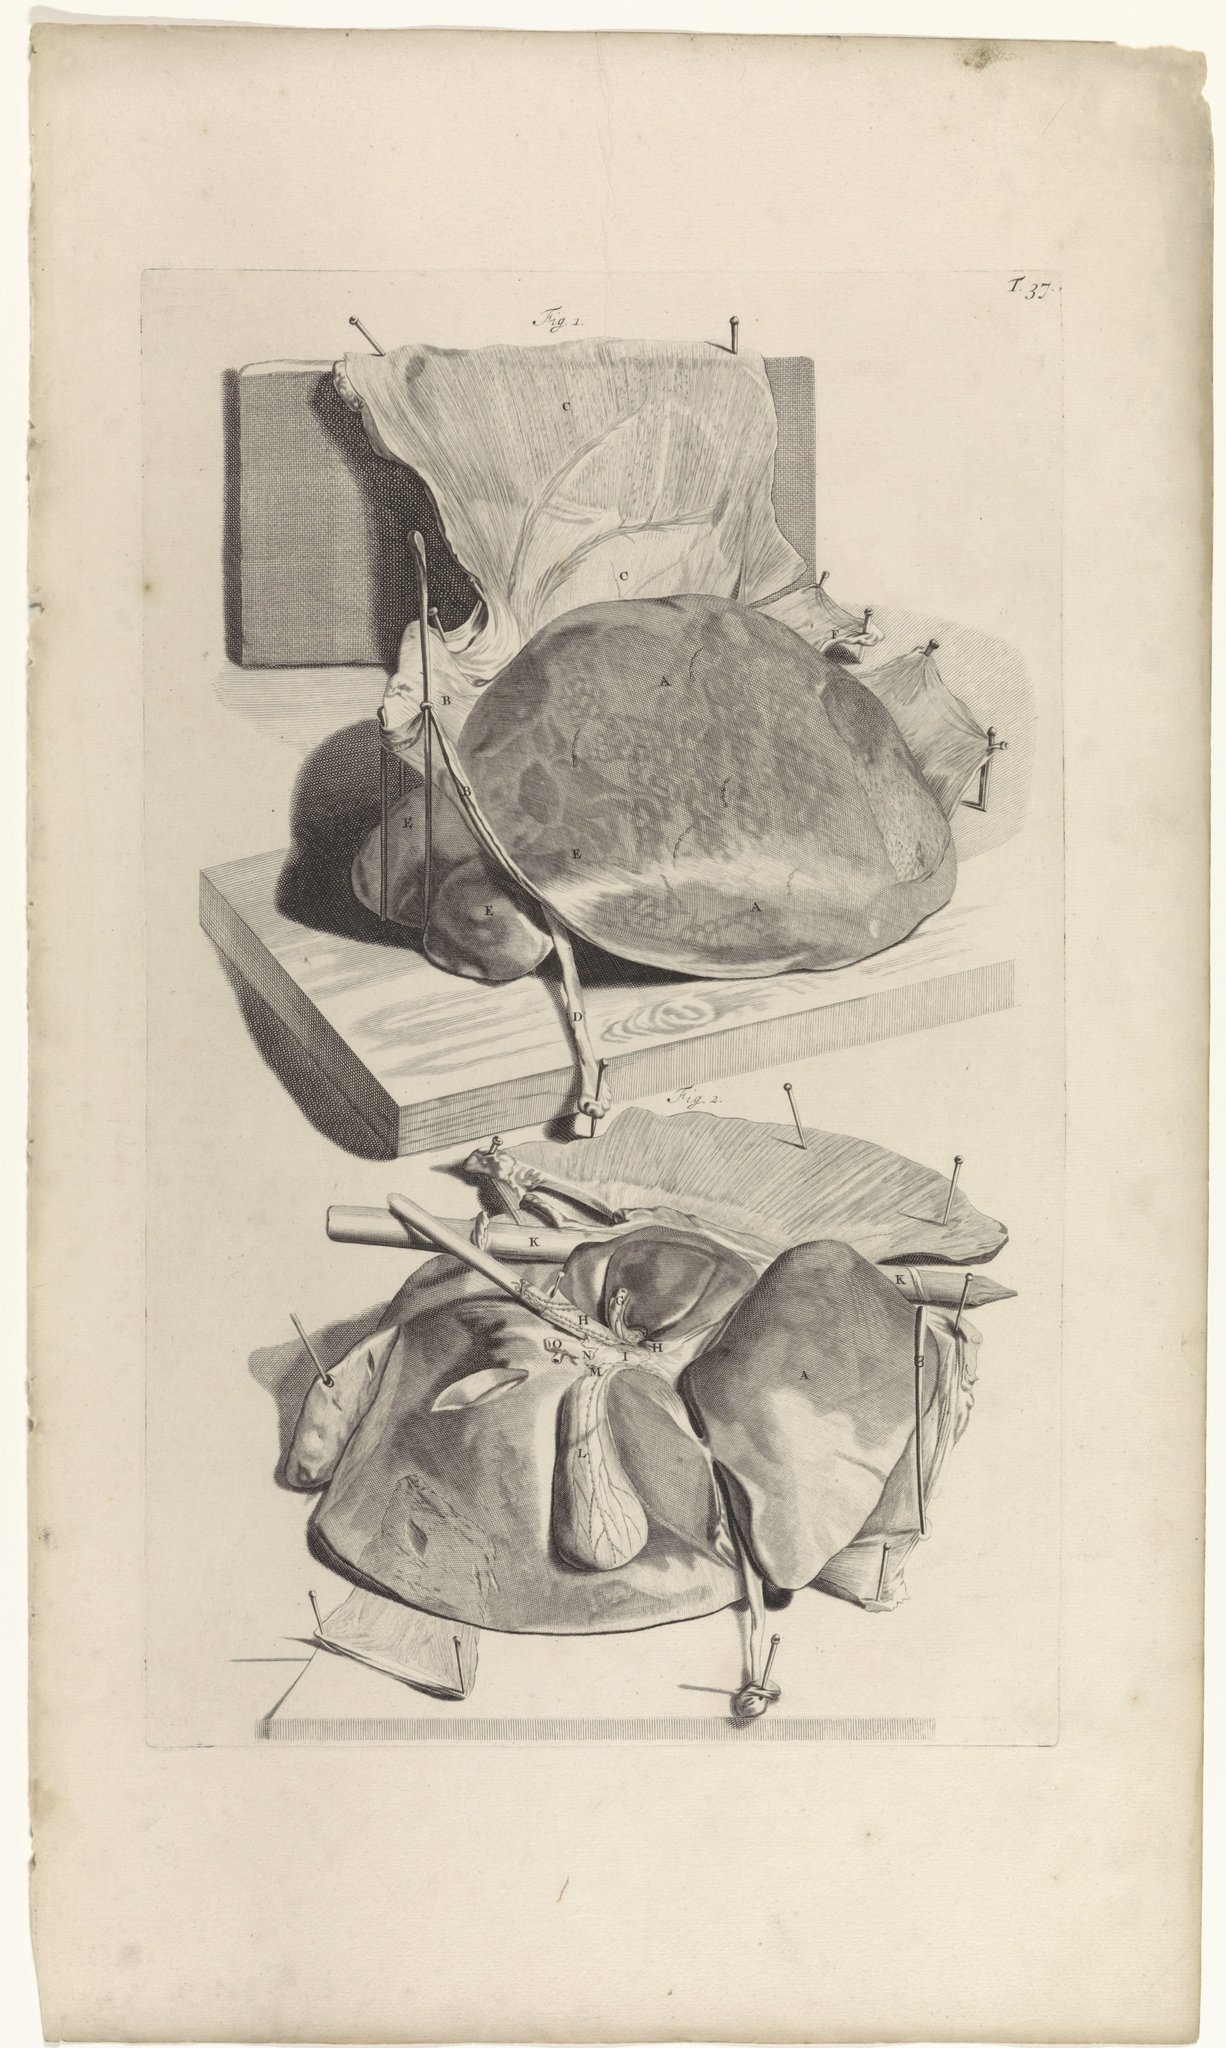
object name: print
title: Anatomische studie van de lever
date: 1685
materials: paper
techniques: engraving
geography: amsterdam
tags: liver (human anatomy)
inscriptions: collector's mark: Lugt 2228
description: Boekillustratie voor Bidloo, Godefridus. Anatomia humani corporis centum & quinque tabulis, per art. G. de Lairesse ad vivum delineatis, de monstrata, veterum recentiorumque inventis explicata plurimisque, hactenus non detectis, illustrata. Amsterdam: Weduwe Joannes van Someren, Hendrick Boom en erven Dirk Boom, 1685.